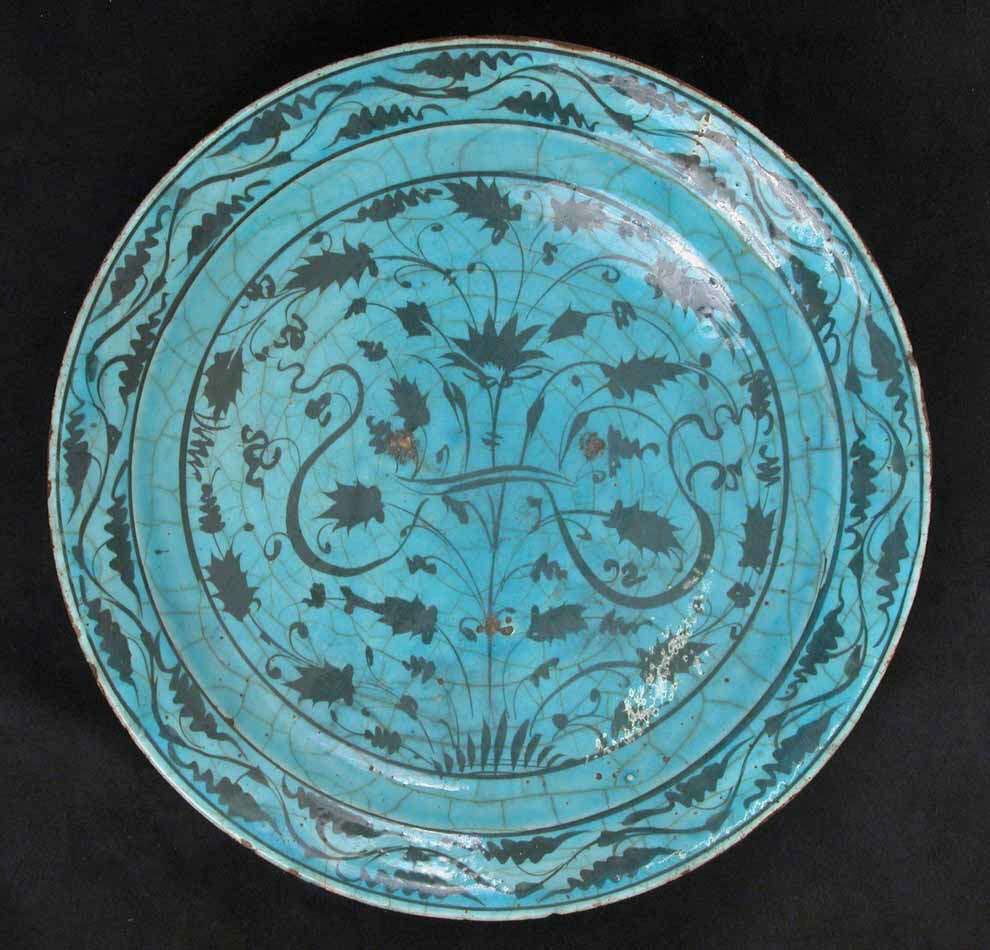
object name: dish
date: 1501-1700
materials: glaze, stonepaste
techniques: painting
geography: iran